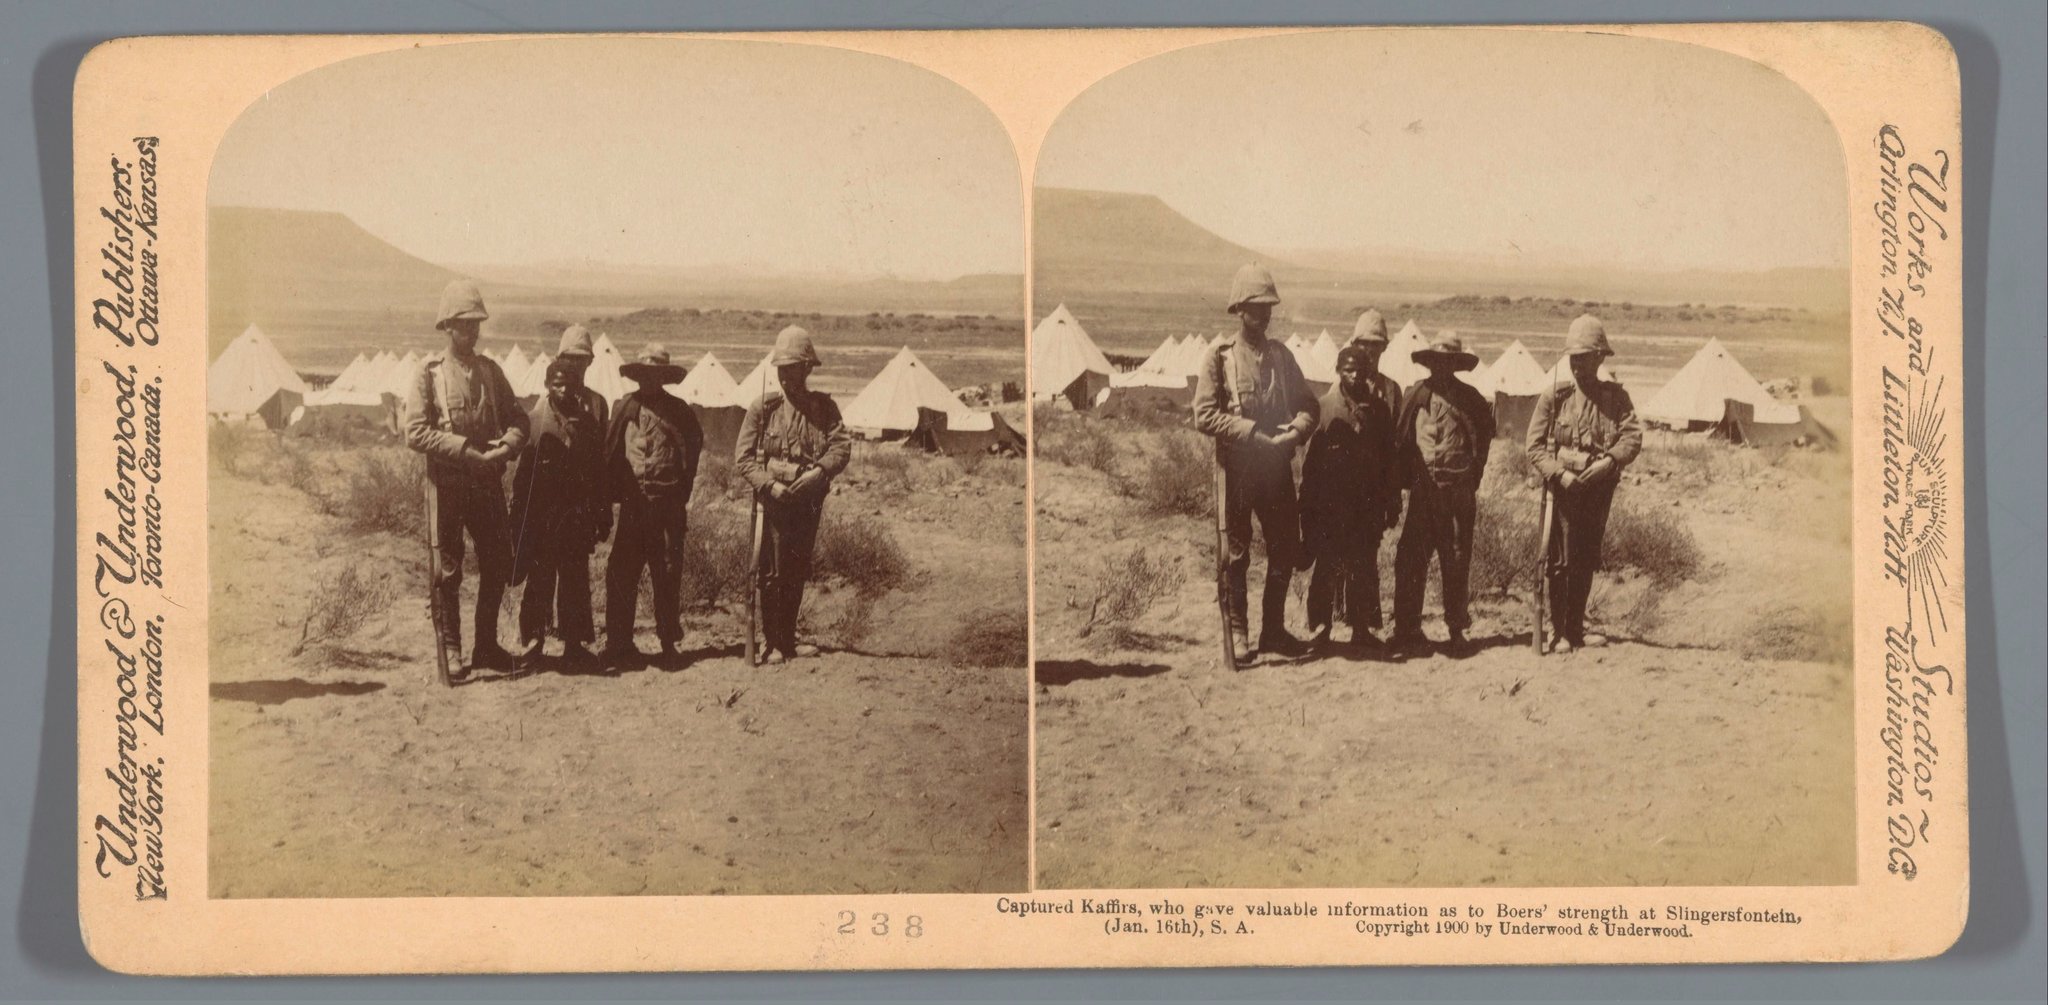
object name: stereograph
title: Britse soldaten en gevangengenomen Afrikanen poseren nabij een legerkamp in de buurt van Slingersfontein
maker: Anonymous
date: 1900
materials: cardboard, paper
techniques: albumen print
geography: new york city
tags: imperialism, soldiers and civilians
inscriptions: inscription, number: ‘238’, copyright notice: ‘Copyright 1900 by Underwood & Underwood.’, inscription: ‘Works and Studios ~/ Arlington, N.J. Littleton, N.H. Washington, D.C.’